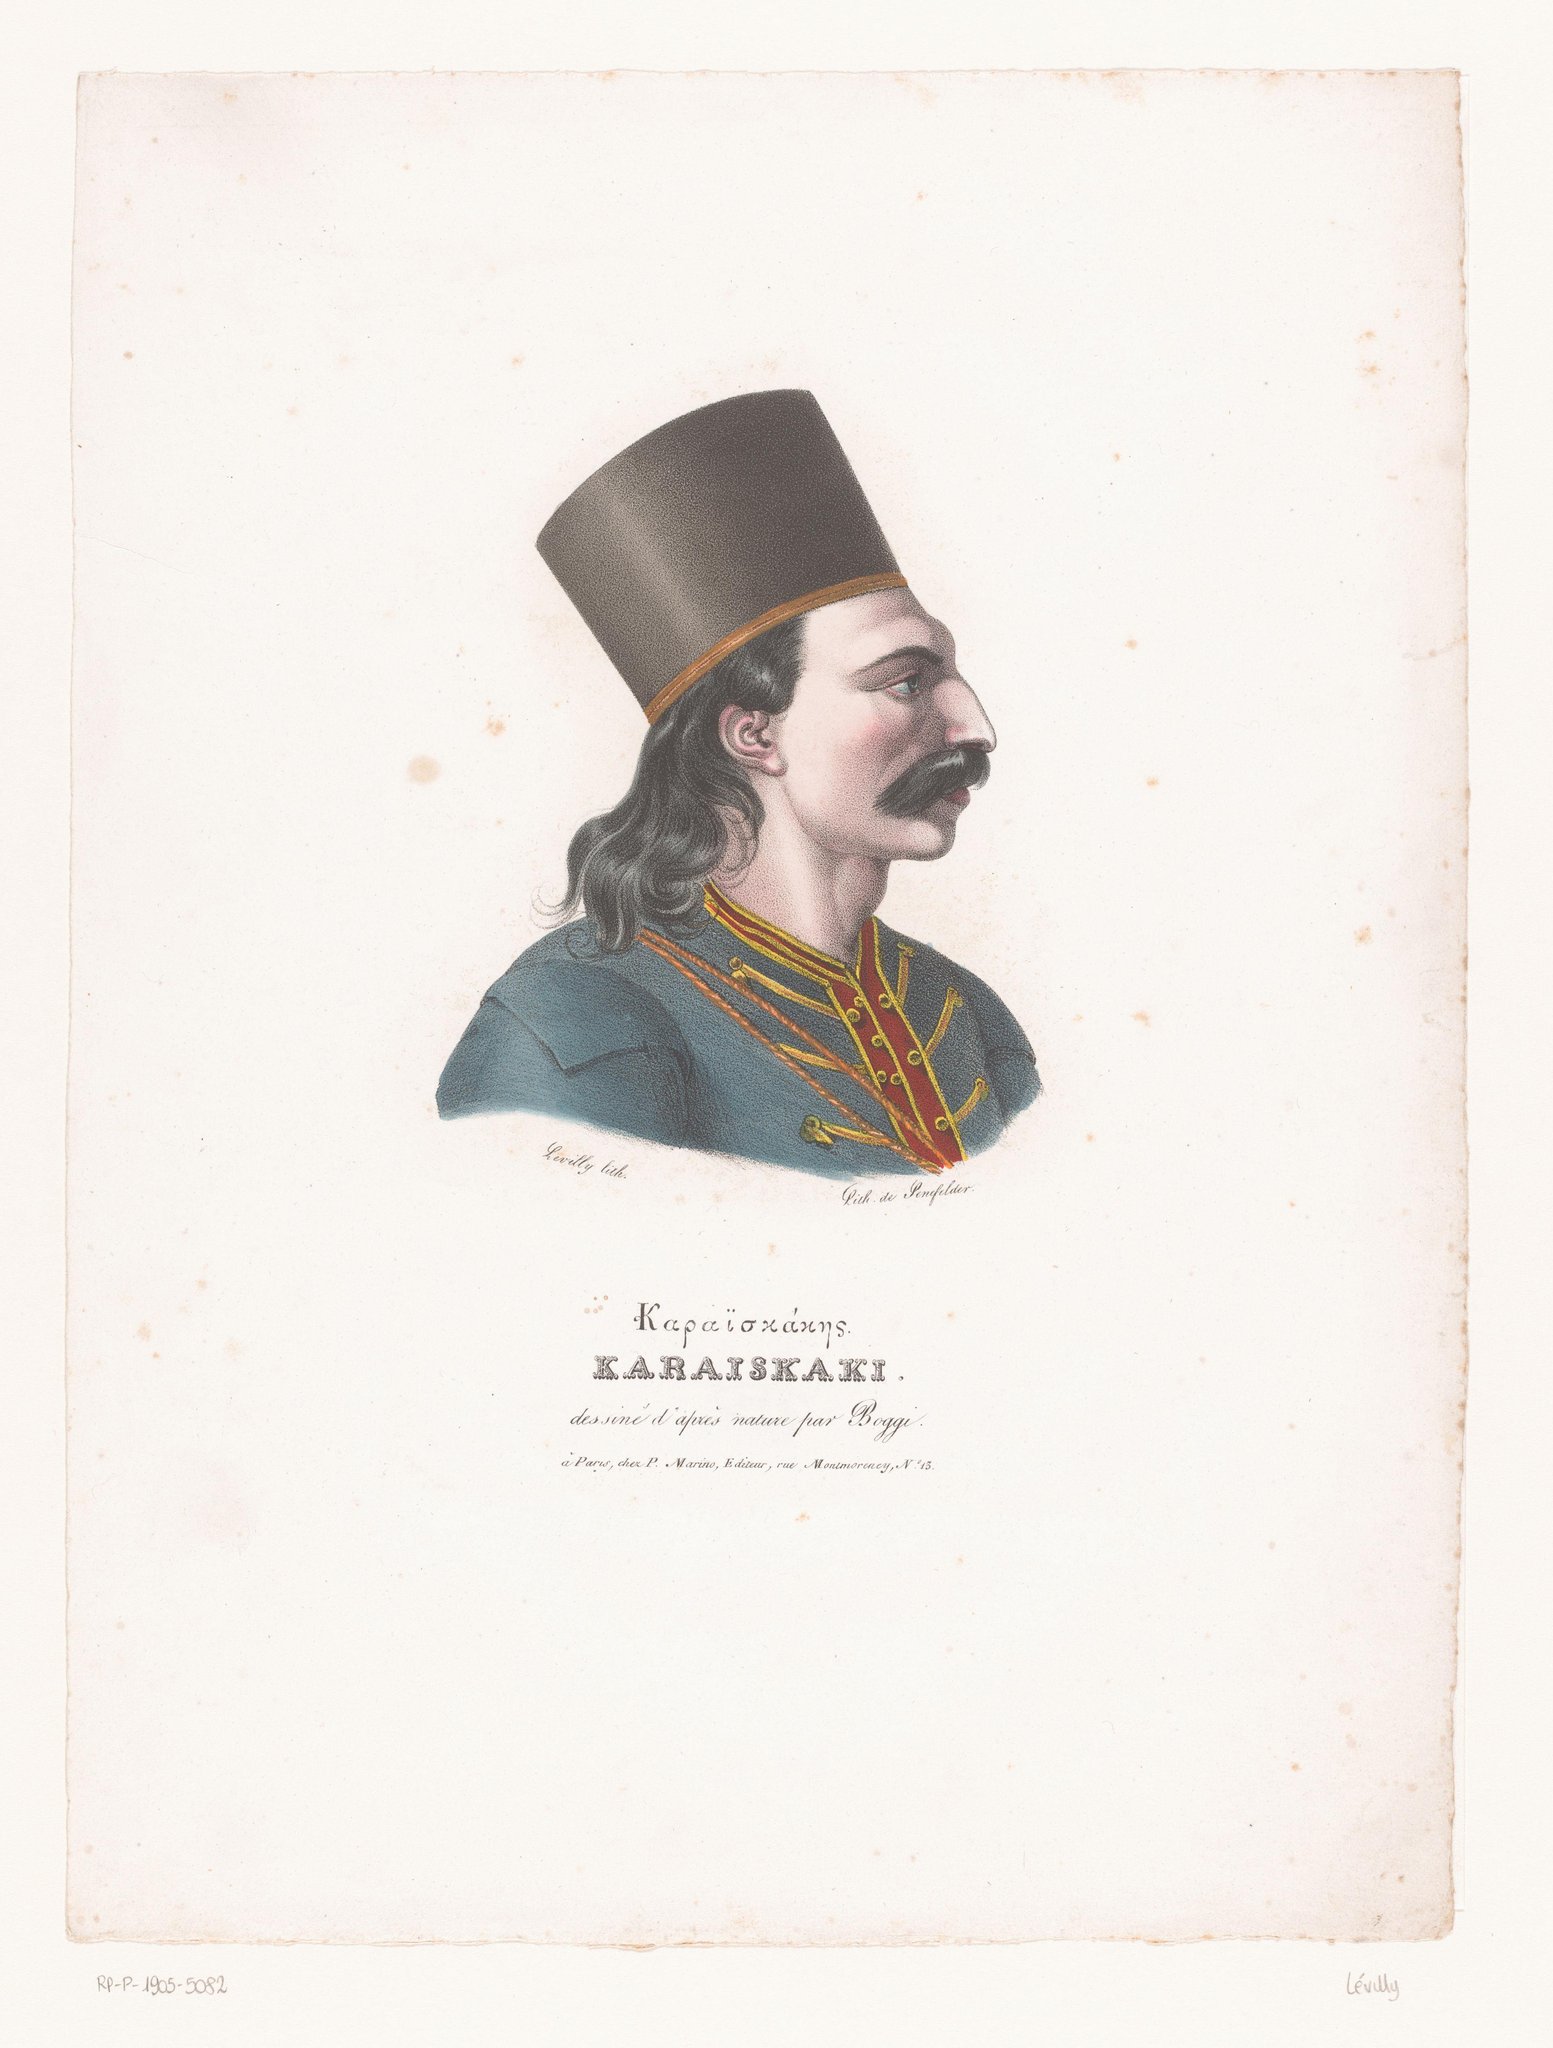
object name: print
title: Karaiskaki, dessiné d'après nature par Boggi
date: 1827-1829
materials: paper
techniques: hand coloring, lithograph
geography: paris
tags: historical persons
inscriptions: collector's mark: Lugt 2228